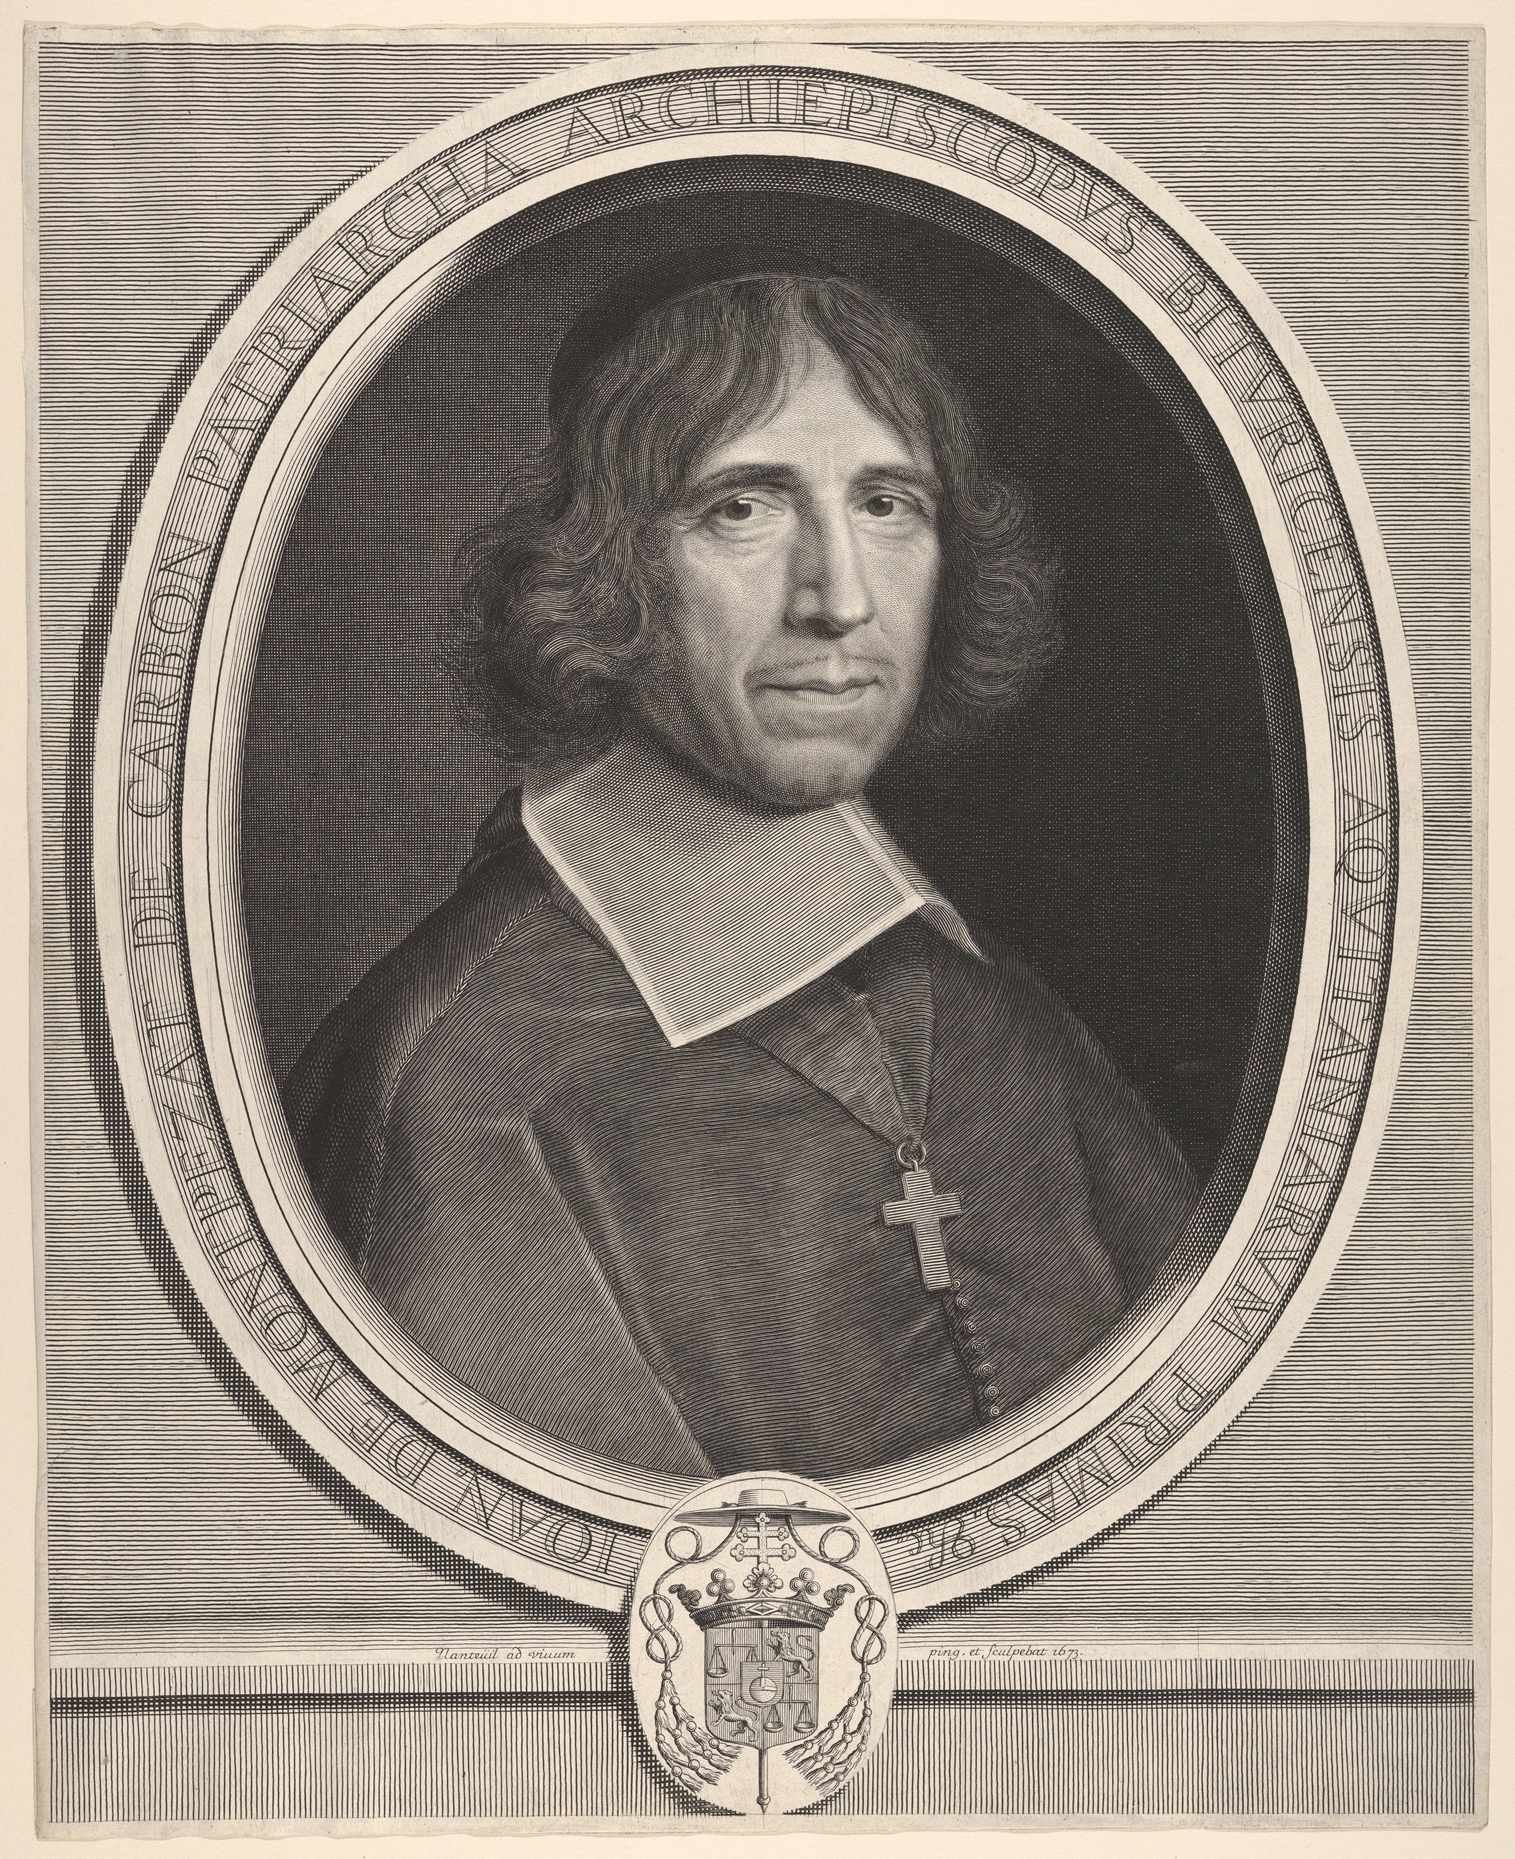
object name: print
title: Jean de Montpezat de Carbon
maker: robert nanteuil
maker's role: artist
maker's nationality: french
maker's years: 1623-1678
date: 1673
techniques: engraving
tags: men,portraits,coat of arms